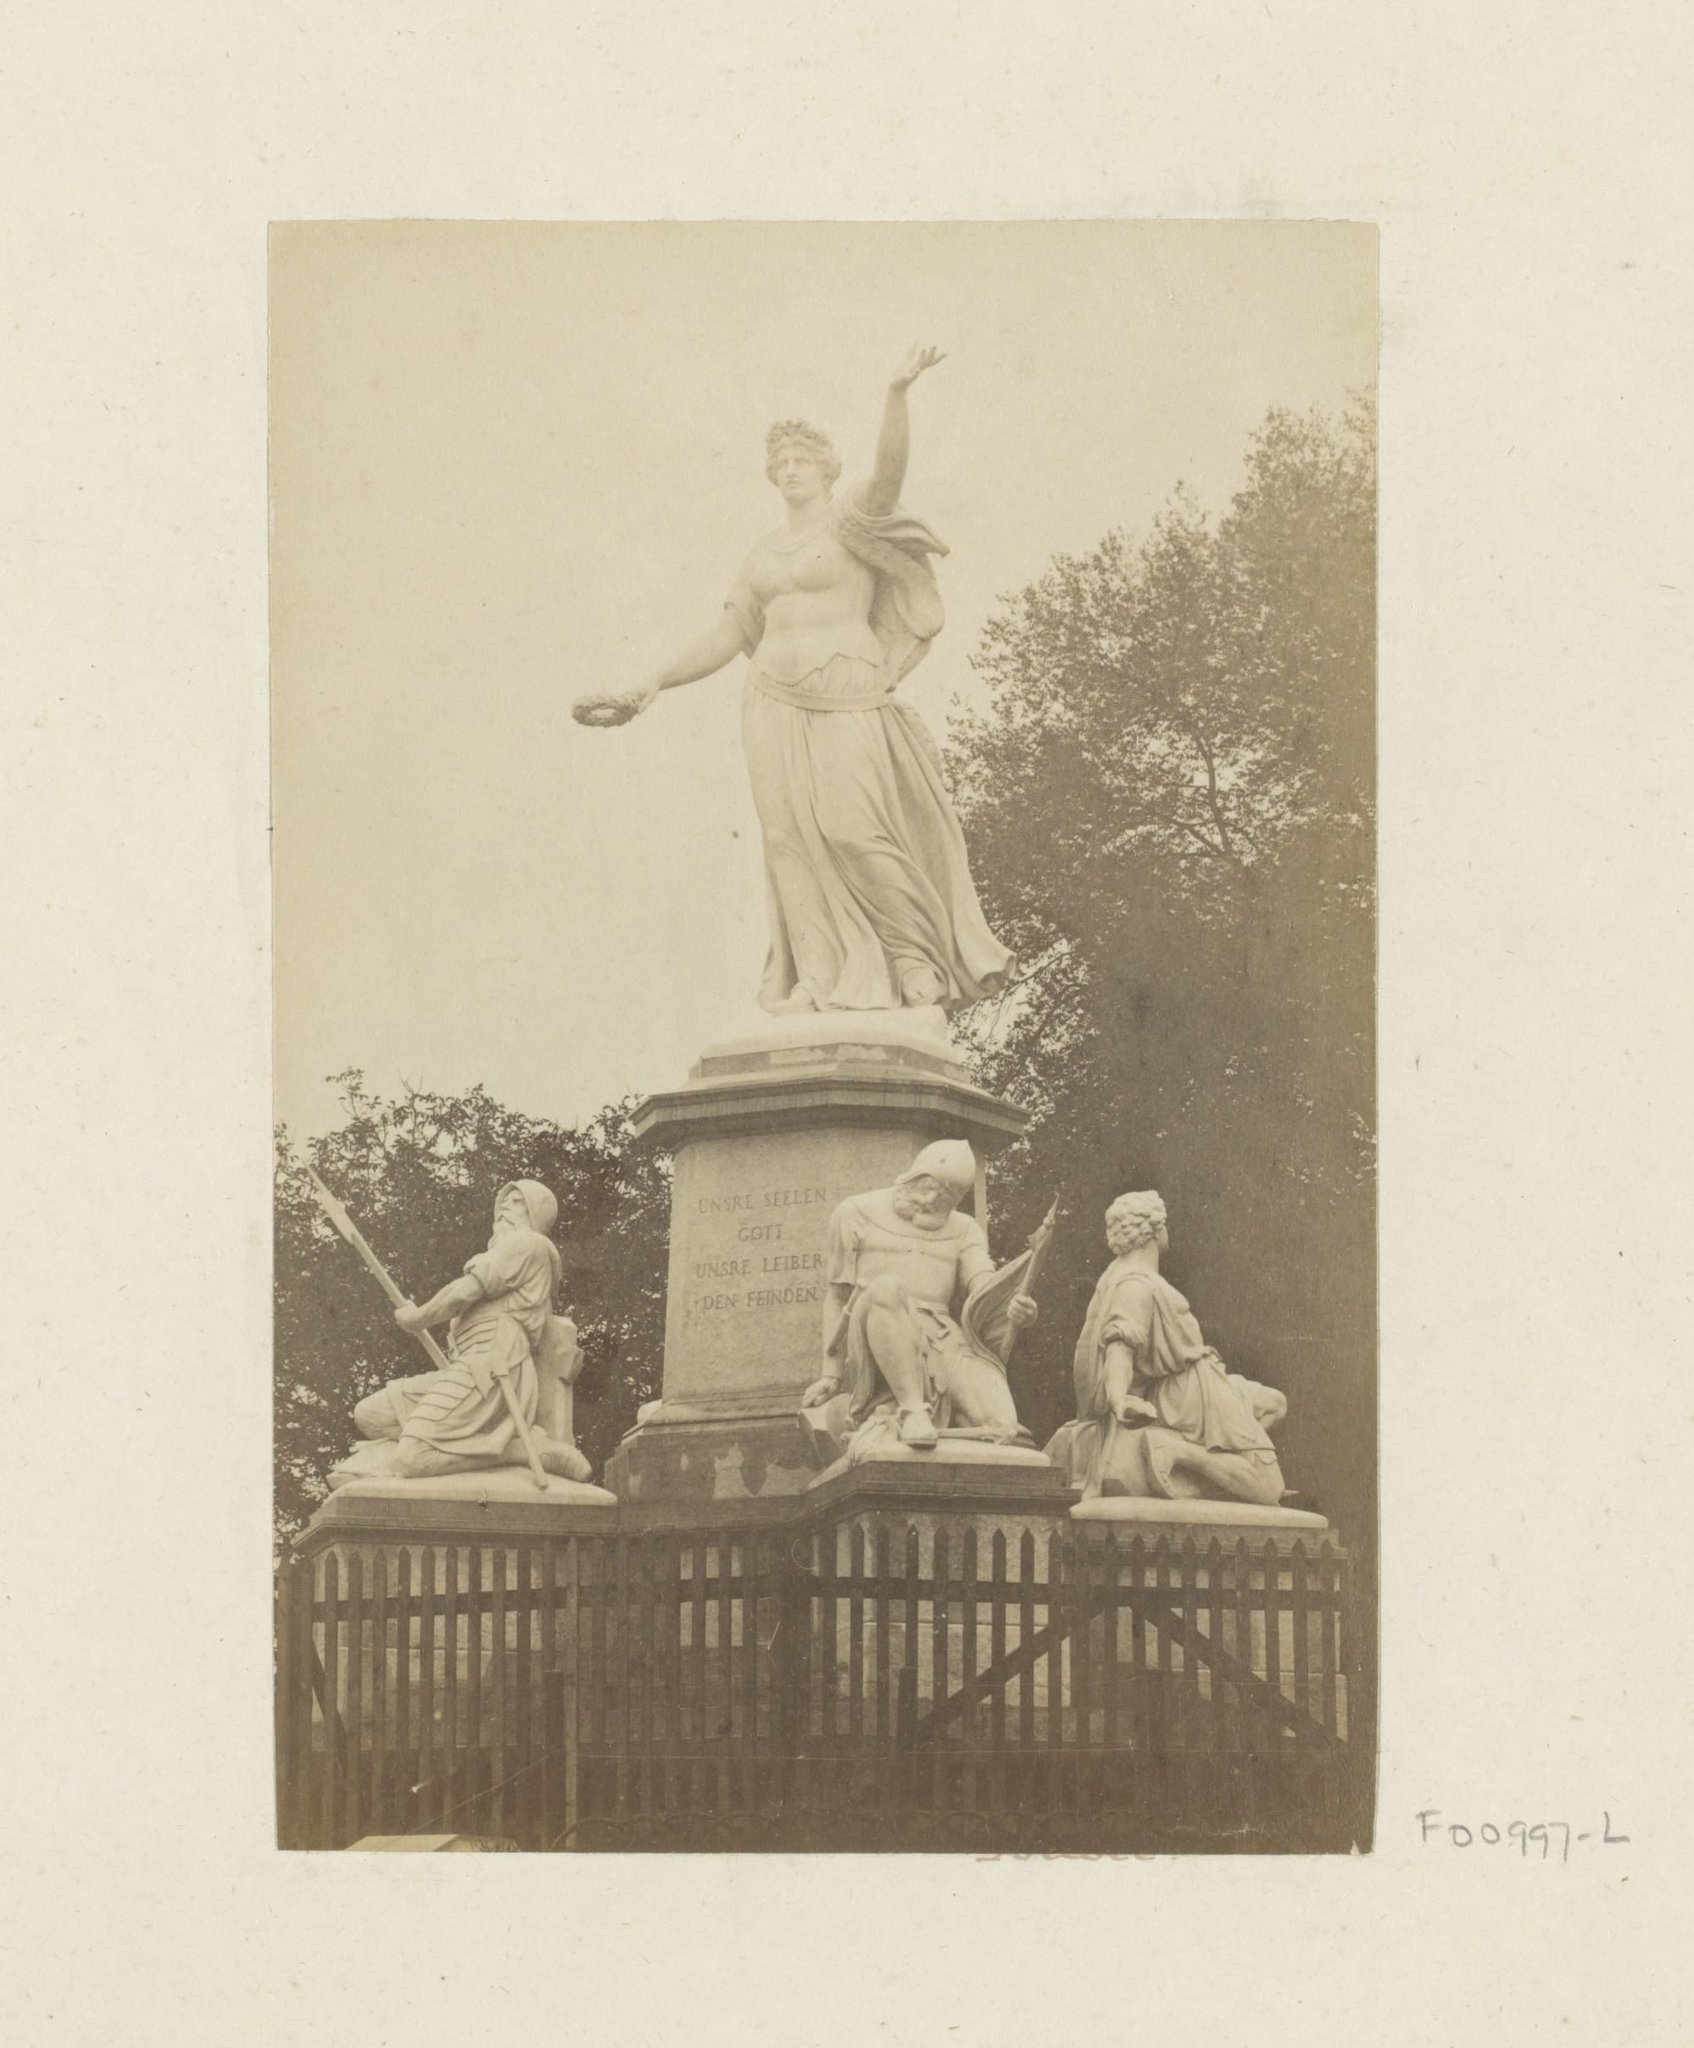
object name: photograph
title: Standbeeld in Bazel met inscriptie 'Unsre Seelen Gott Unsre Leiber den Feinden'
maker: Anonymous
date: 1860-1890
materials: paper, photographic support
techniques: albumen print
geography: basel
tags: monument, statue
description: Onderdeel van Reisalbum met foto's van Zwitserland, Oostenrijk, Italië en Duitsland.